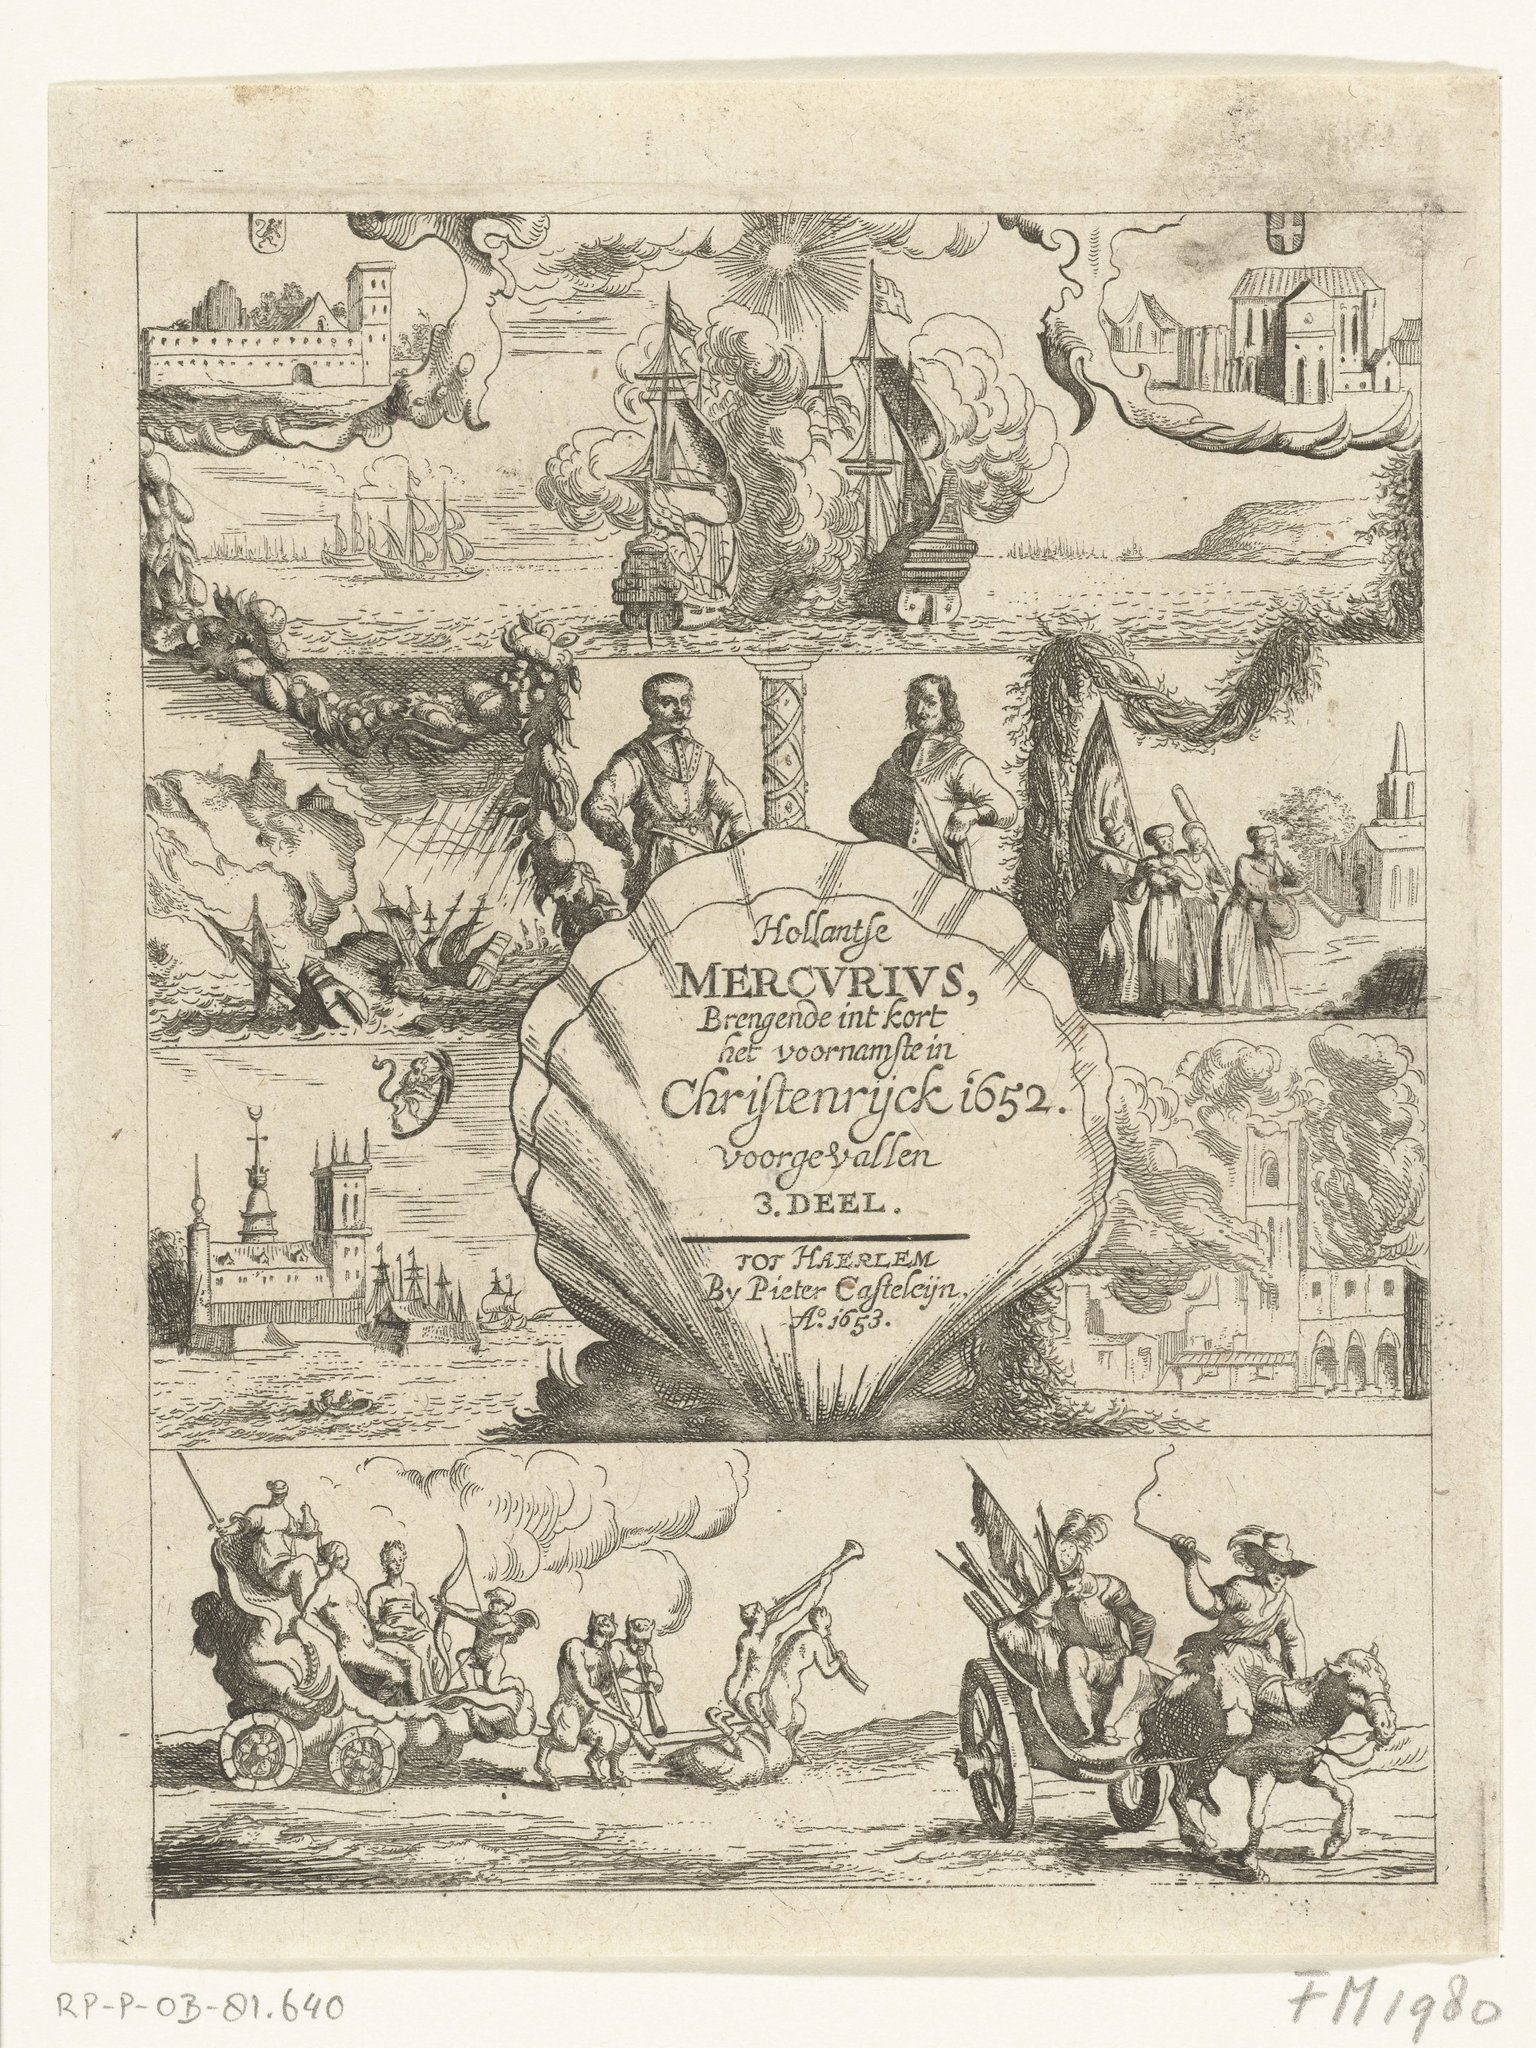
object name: titelblad, titelpagina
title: Titelprent voor de Hollantsche Mercurius van 1652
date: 1653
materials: paper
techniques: etching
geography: haarlem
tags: warfare; military affairs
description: Titelprent voor de Hollantsche Mercurius (derde deel) van 1652. Vier stroken met in het klein de belangrijkste gebeurtenissen uit het jaar 1652, waaronder de Eerste Engelse Oorlog. Centraal een schelp met de titel.